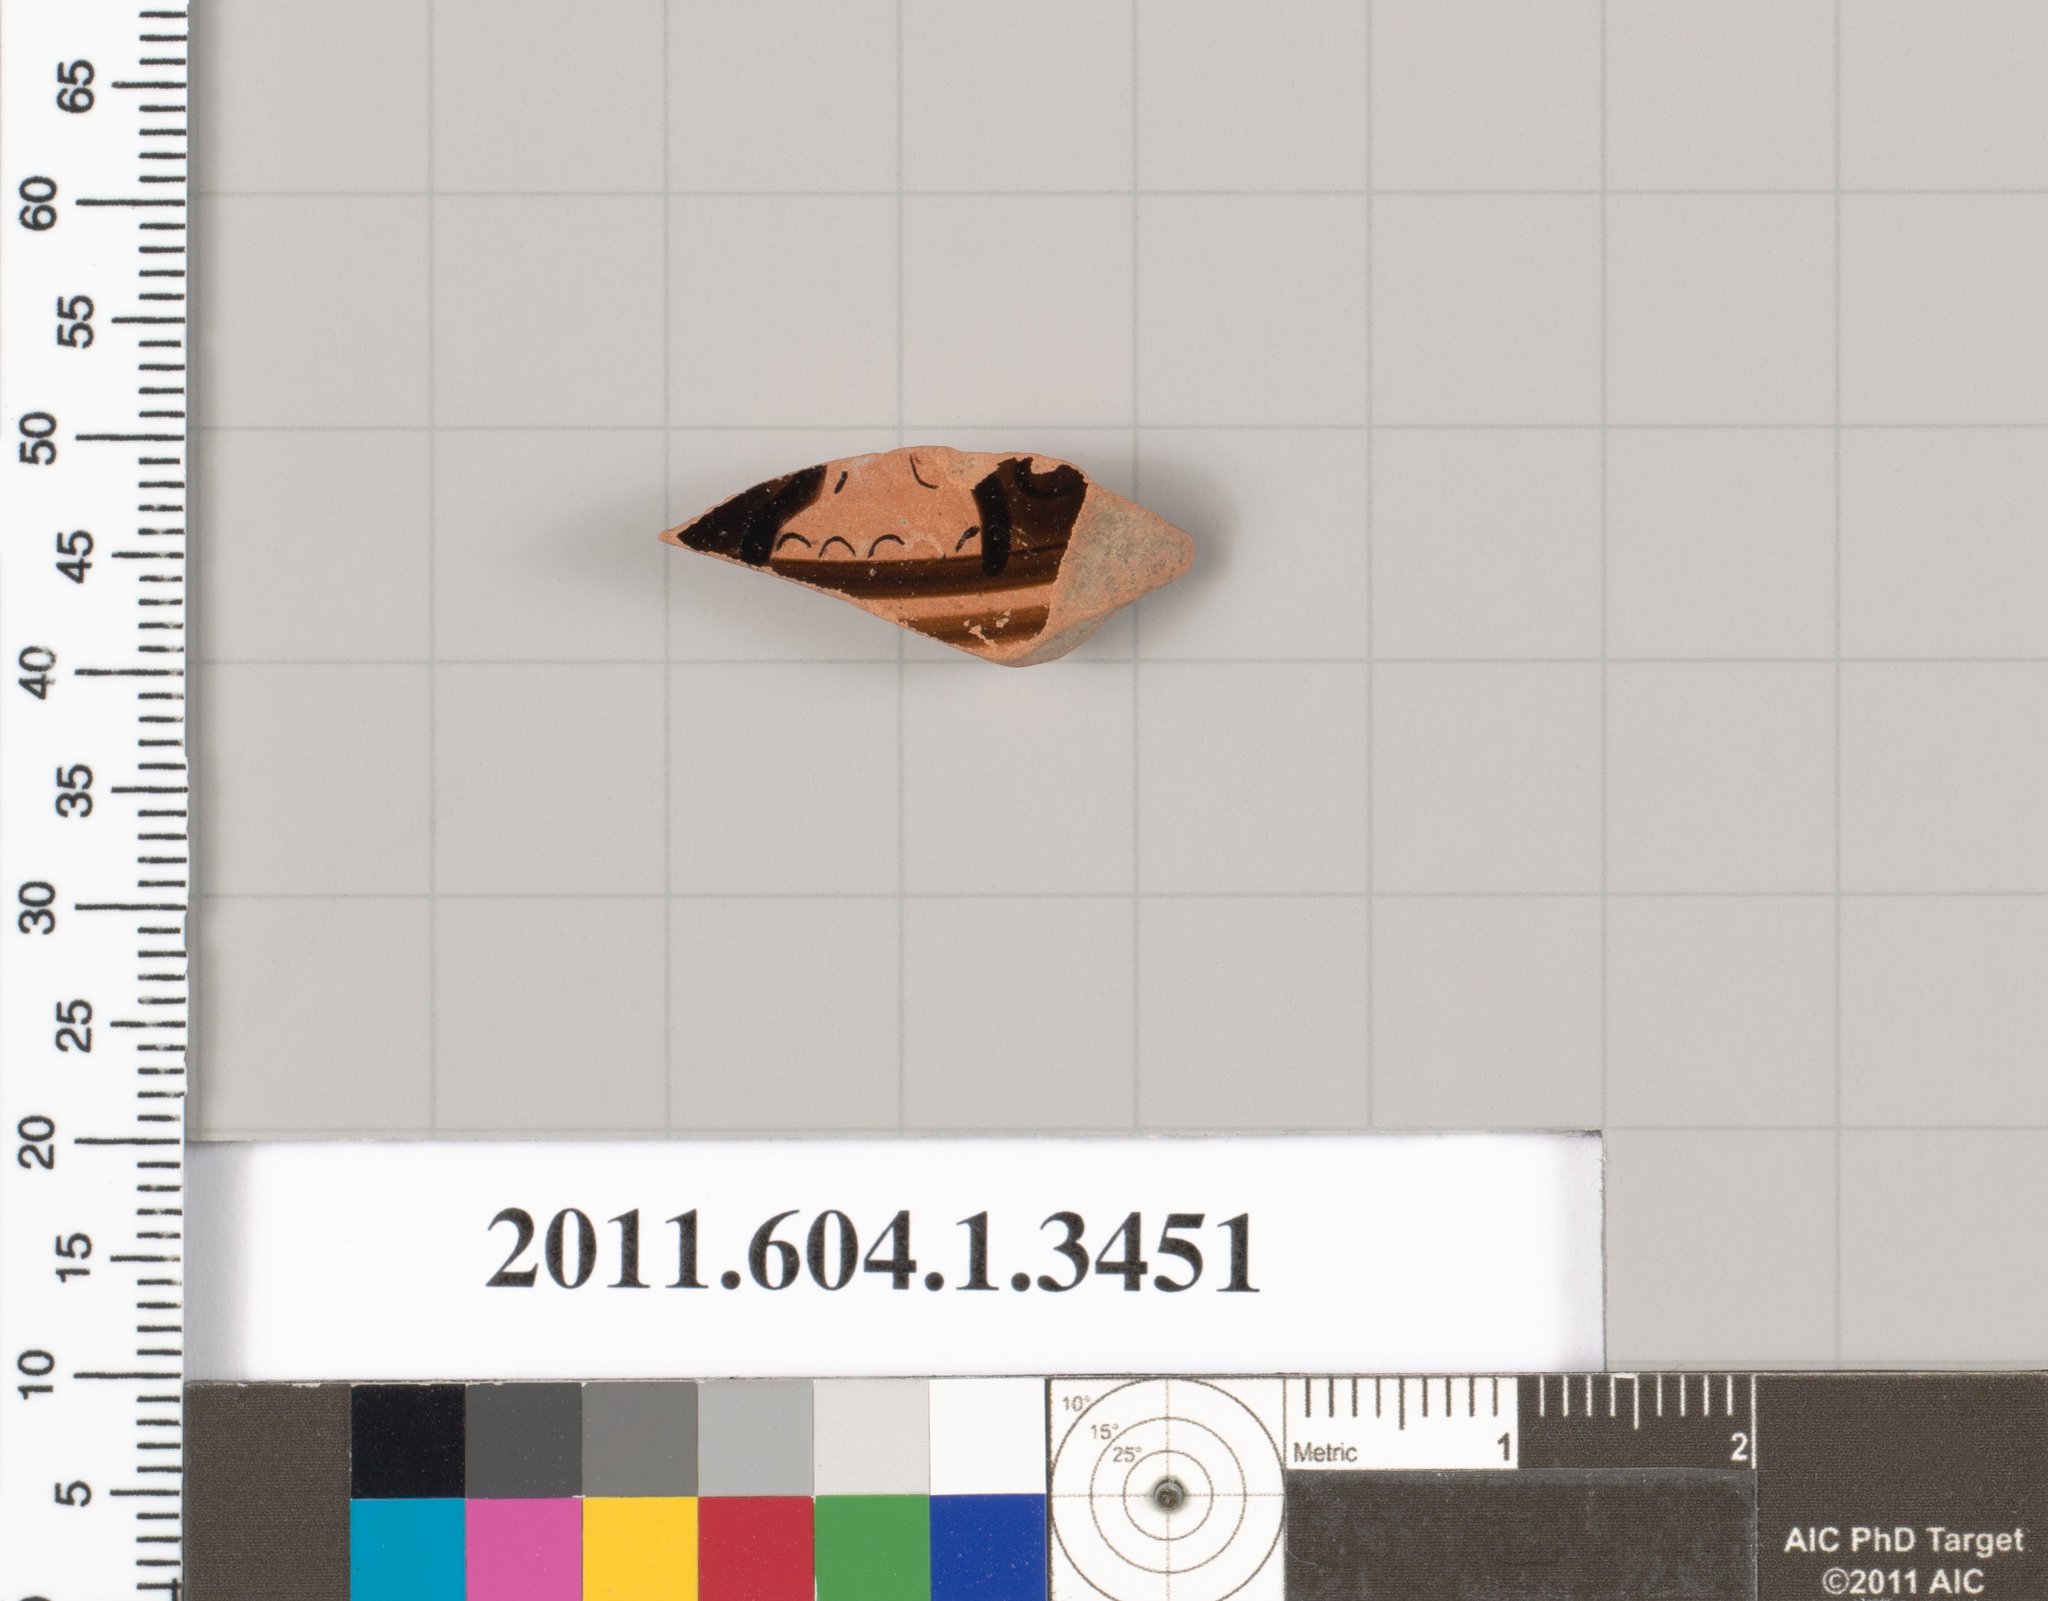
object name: kylix fragment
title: Terracotta fragment of a kylix (drinking cup)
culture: greek, attic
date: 475-451 BCE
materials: terracotta